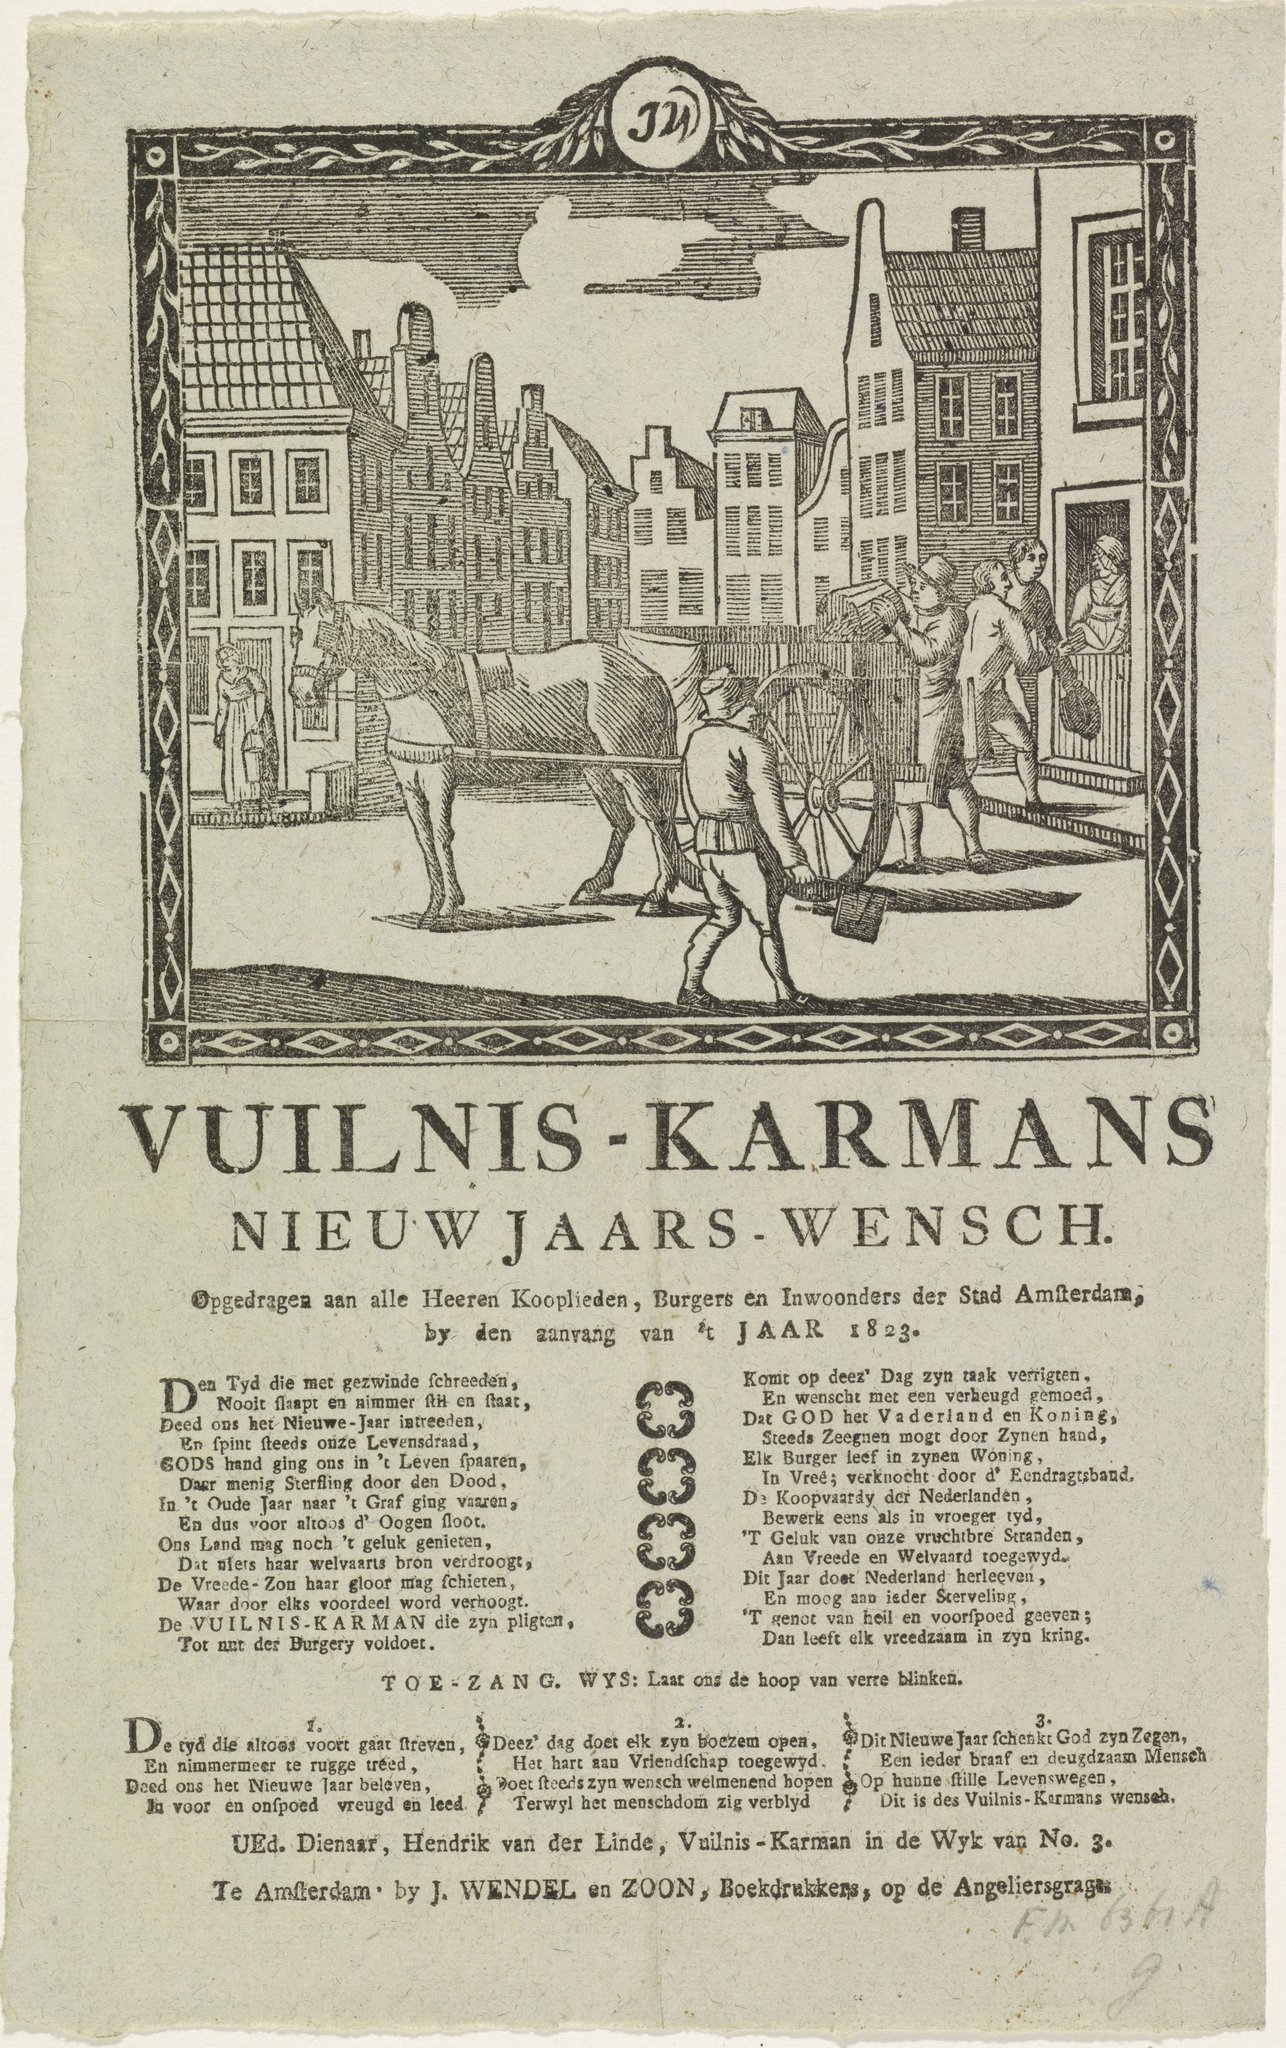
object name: new year card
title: Nieuwjaarswens van de vuilnismannen van Amsterdam voor het jaar 1823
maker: Anonymous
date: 1822-1823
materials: paper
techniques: letterpress printing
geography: amsterdam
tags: street, garbage collection, amsterdam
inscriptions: collector's mark: Lugt 2228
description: Nieuwjaarswens van de Amsterdamse vuilnismannen voor het jaar 1823. Gezicht in een straat te Amsterdam waar twee mannen met een kar het vuil ophalen. Twee andere mannen halen bij een huis geld op. Met gedicht in twee kolommen en een lied in drie verzen. Van de vuilniskarman in de wijk no. 3: Hendrik van der Linde.